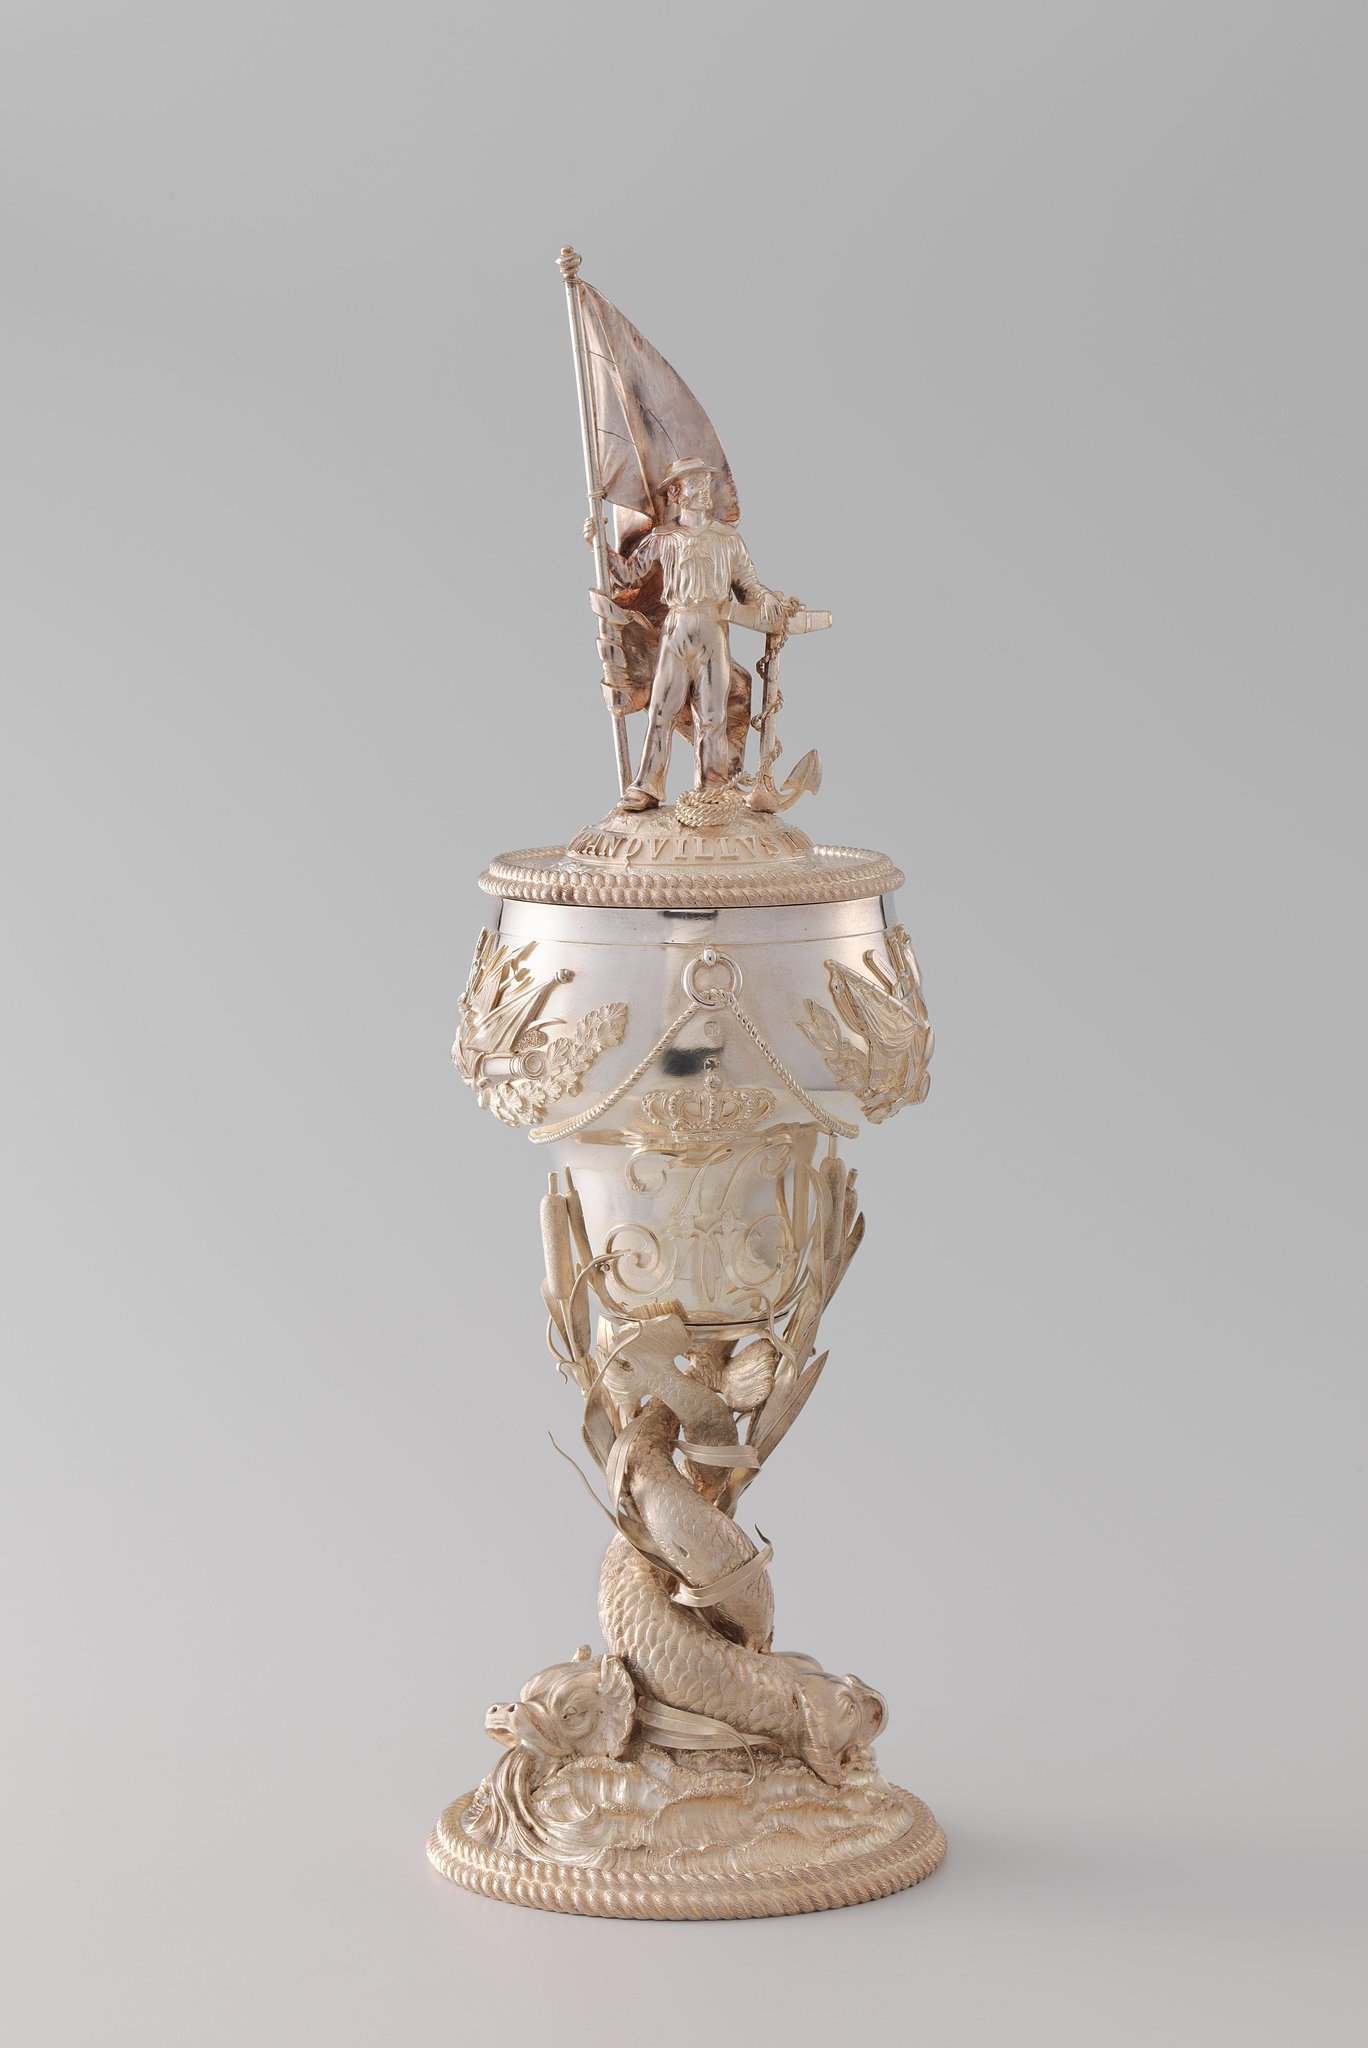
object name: cup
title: Silver Birthday Cup for Lieutenant Admiral Engelbert Lucas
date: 1865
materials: silver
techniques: casting, gilding, riveted, screwed, soldering, striking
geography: voorschoten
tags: the hague, engelbertus lucas, hendrik (prins der nederlanden)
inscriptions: inscription: ‘SAEVIS TRANQVILLVS IN VNDIS.’, hallmark, maker's mark, date letter: ‘F’, inscription: ‘Aan / DEN LUITENANT- / ADMIRAAL / E. LUCAS / Bij het vieren / van zijnen 80sten geboortedag / en als hulde / voor meer dan 70 jaren getrouwe dienst / door hem aan den Lande bewezen / aangeboden / door Z.K.H. PRINS Hendrik / der Nederlanden / LUITENANT ADMIRAAL / Opperbevelheber der vloot / den 30 mei 1865.’, maker's mark, retailer's mark: ‘VAN KEMPEN / HOFLEVERANCIER’, alloy mark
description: Zilveren bokaal, de kelk met aan beide zijden krijgs- en marine-attributen, een gekroonde H en opschrift. De schacht bestaat uit twee verstrengelde waterspuwende fantasievissen en riet, de voet heeft een reliëf als water en de randen omsnoerd door kabels. Gemerkt met meestertekens van Van Kempen, jaarletter F (=1865), Minervakop en keurmerken.